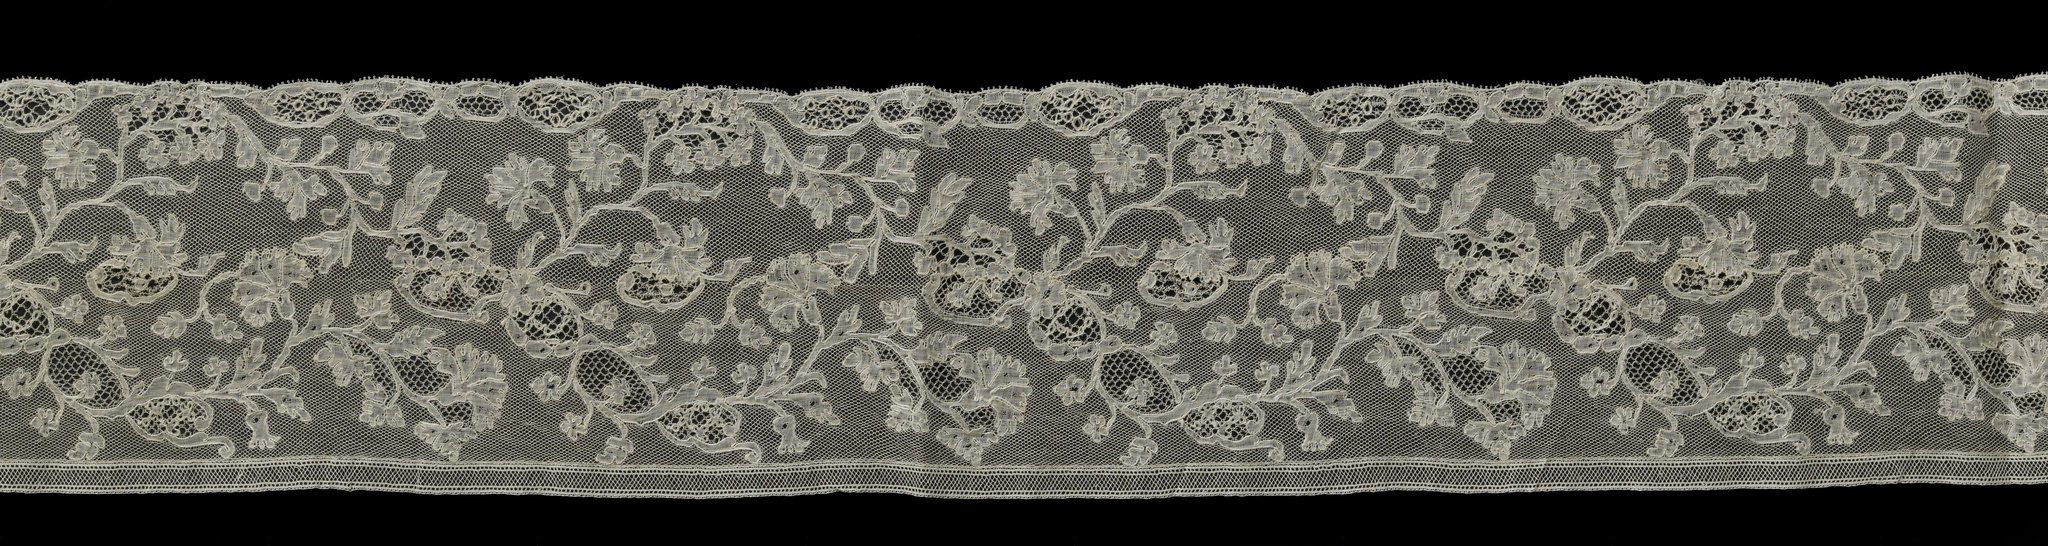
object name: strip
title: Japonstrook van kloskant met reserves en anjers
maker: Anonymous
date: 1850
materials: linen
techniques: lace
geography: bruges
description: Deze strook en de bijbehorende strook zijn opgeborgen in een doos beplakt met goudgebiesd wit moire-papier. Op de doos staan met gouden letters de initialen M.V.H. Dit staat voor Mary (Ethel) Vernon Harcourt, Viscountess Harcourt (voor haar trouwen met Lewis Vernon Harcourt, 1st Viscount Harcourt heette ze Haynes Burns). Op de lichtblauwe binnenkant van de doos staat in gouden letters Worth (adres?). De stroken waren met spelden aan een lichtblauw lint vastgemaakt op een donkerder blauw karton. Het karton met de linten zit onderin de doos.